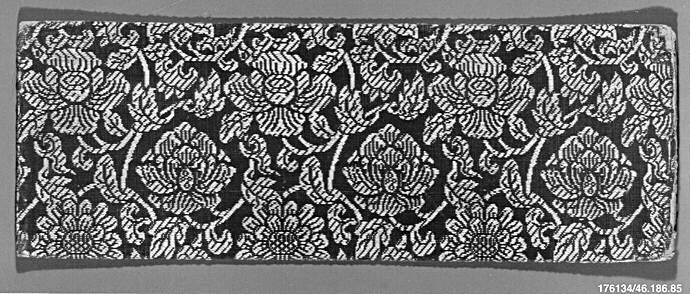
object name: sutra cover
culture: chinese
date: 1701-1800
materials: silk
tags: flowers